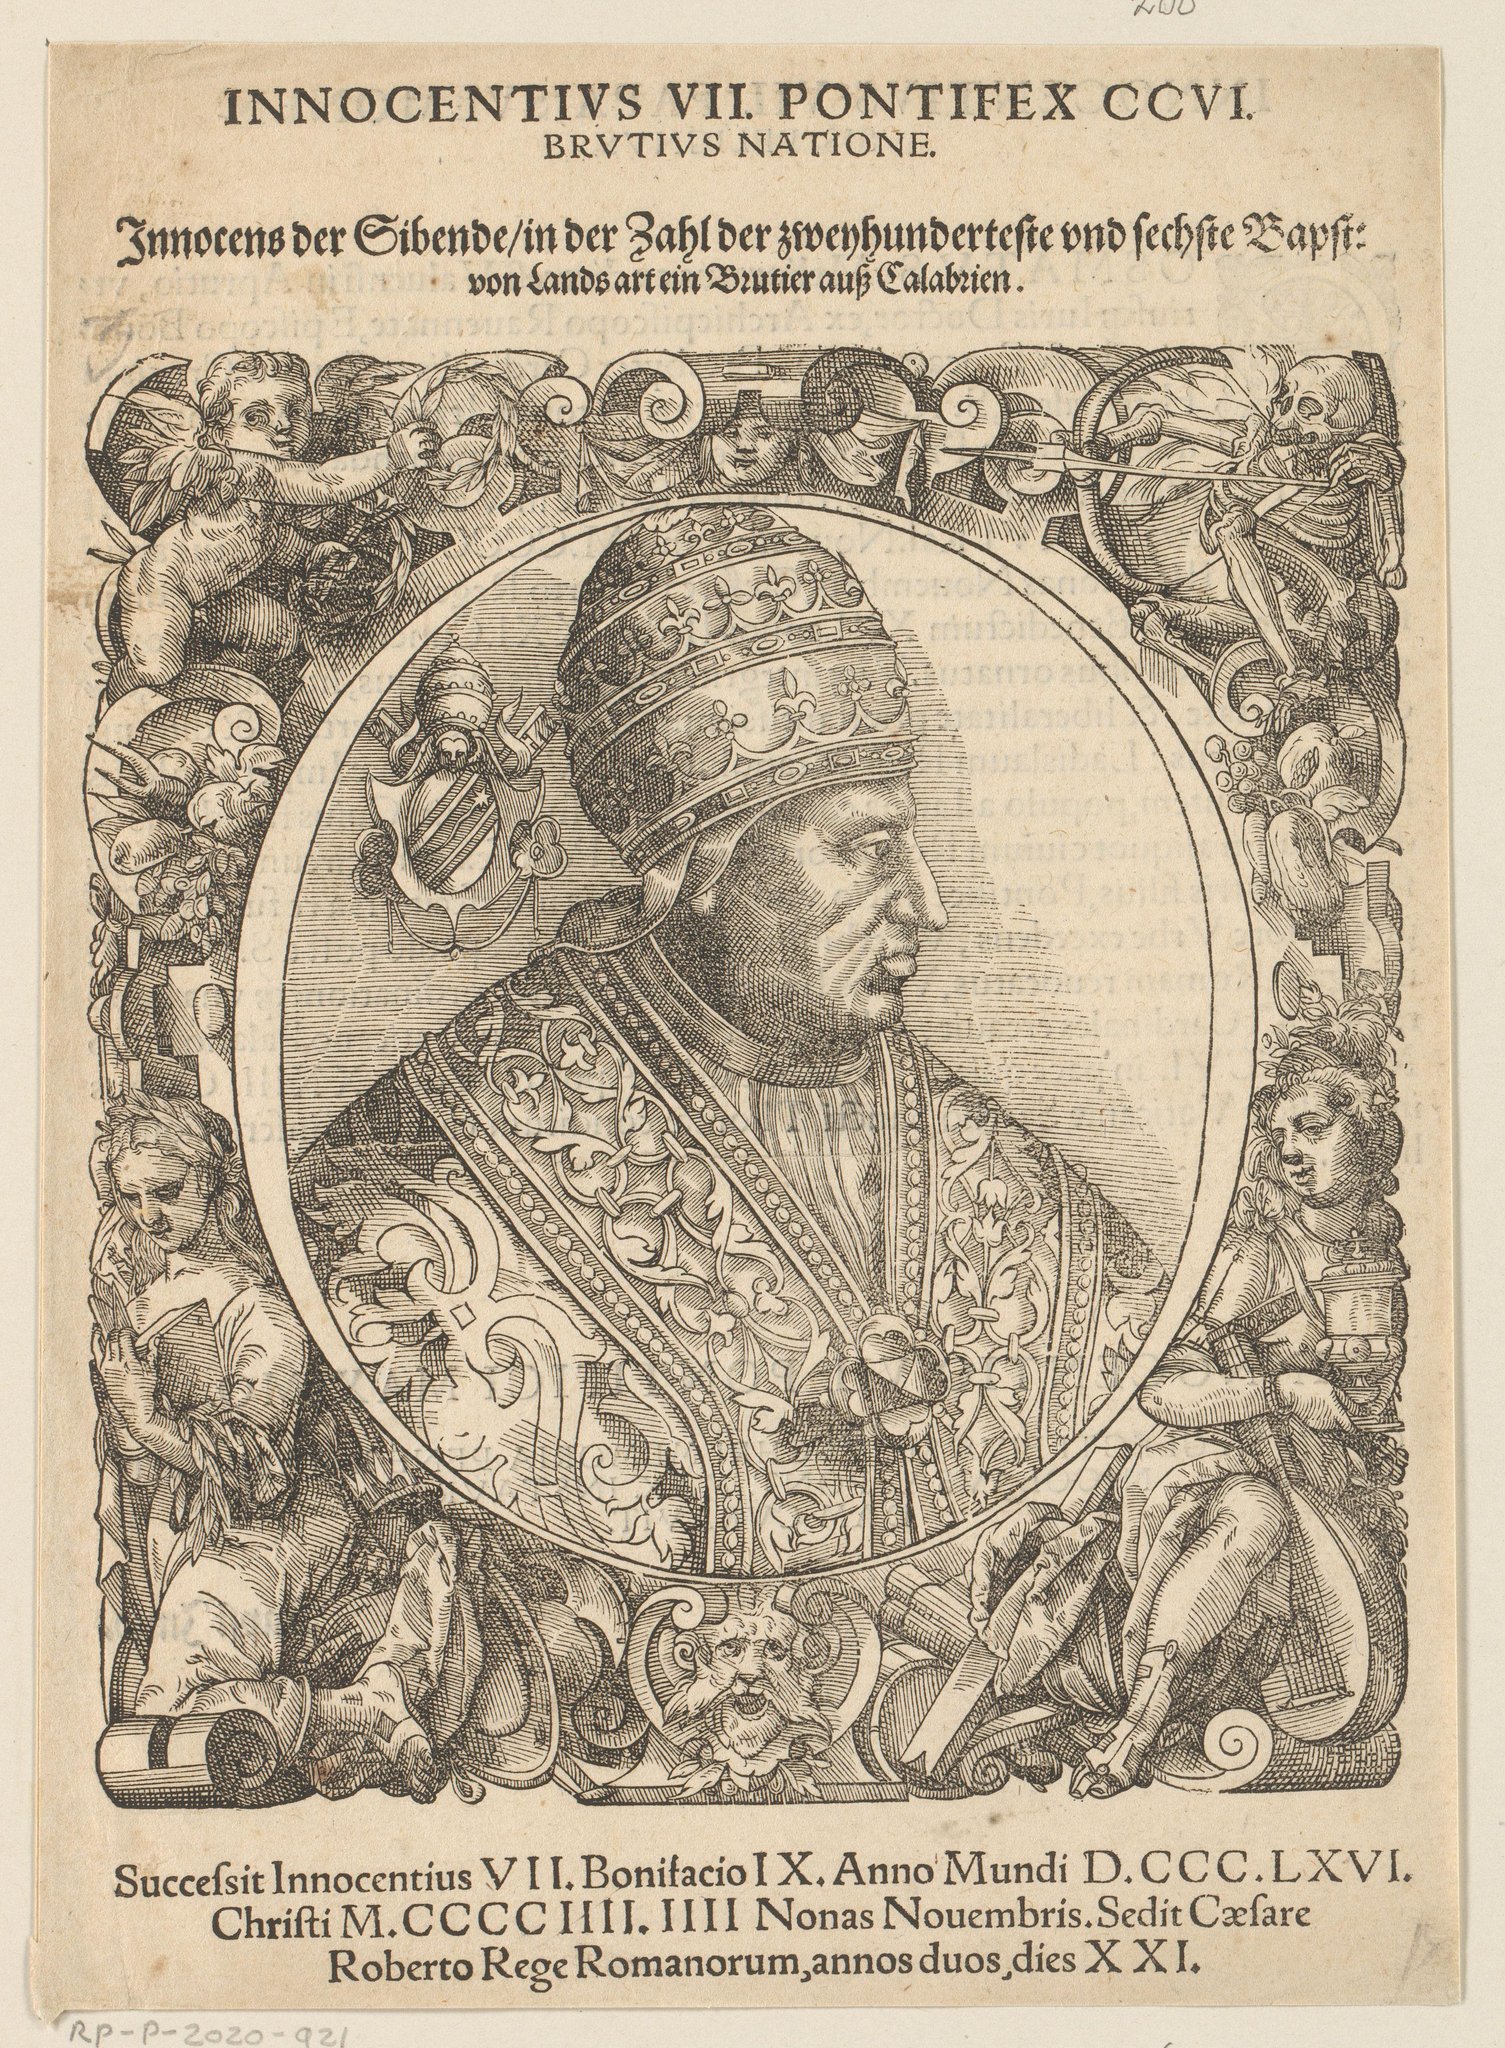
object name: print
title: Portret van paus Innocentius VII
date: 1573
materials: paper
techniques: letterpress printing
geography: straatsburg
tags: historical persons, pope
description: Prent uit: Panvinio, Onofrio. Accurate effigies pontificum maximorum, numero XXVIII: ab anno Christi MCCCLXXVIII ad aetatum (...). Straatsburg: Bernhard Jobin, 1573.